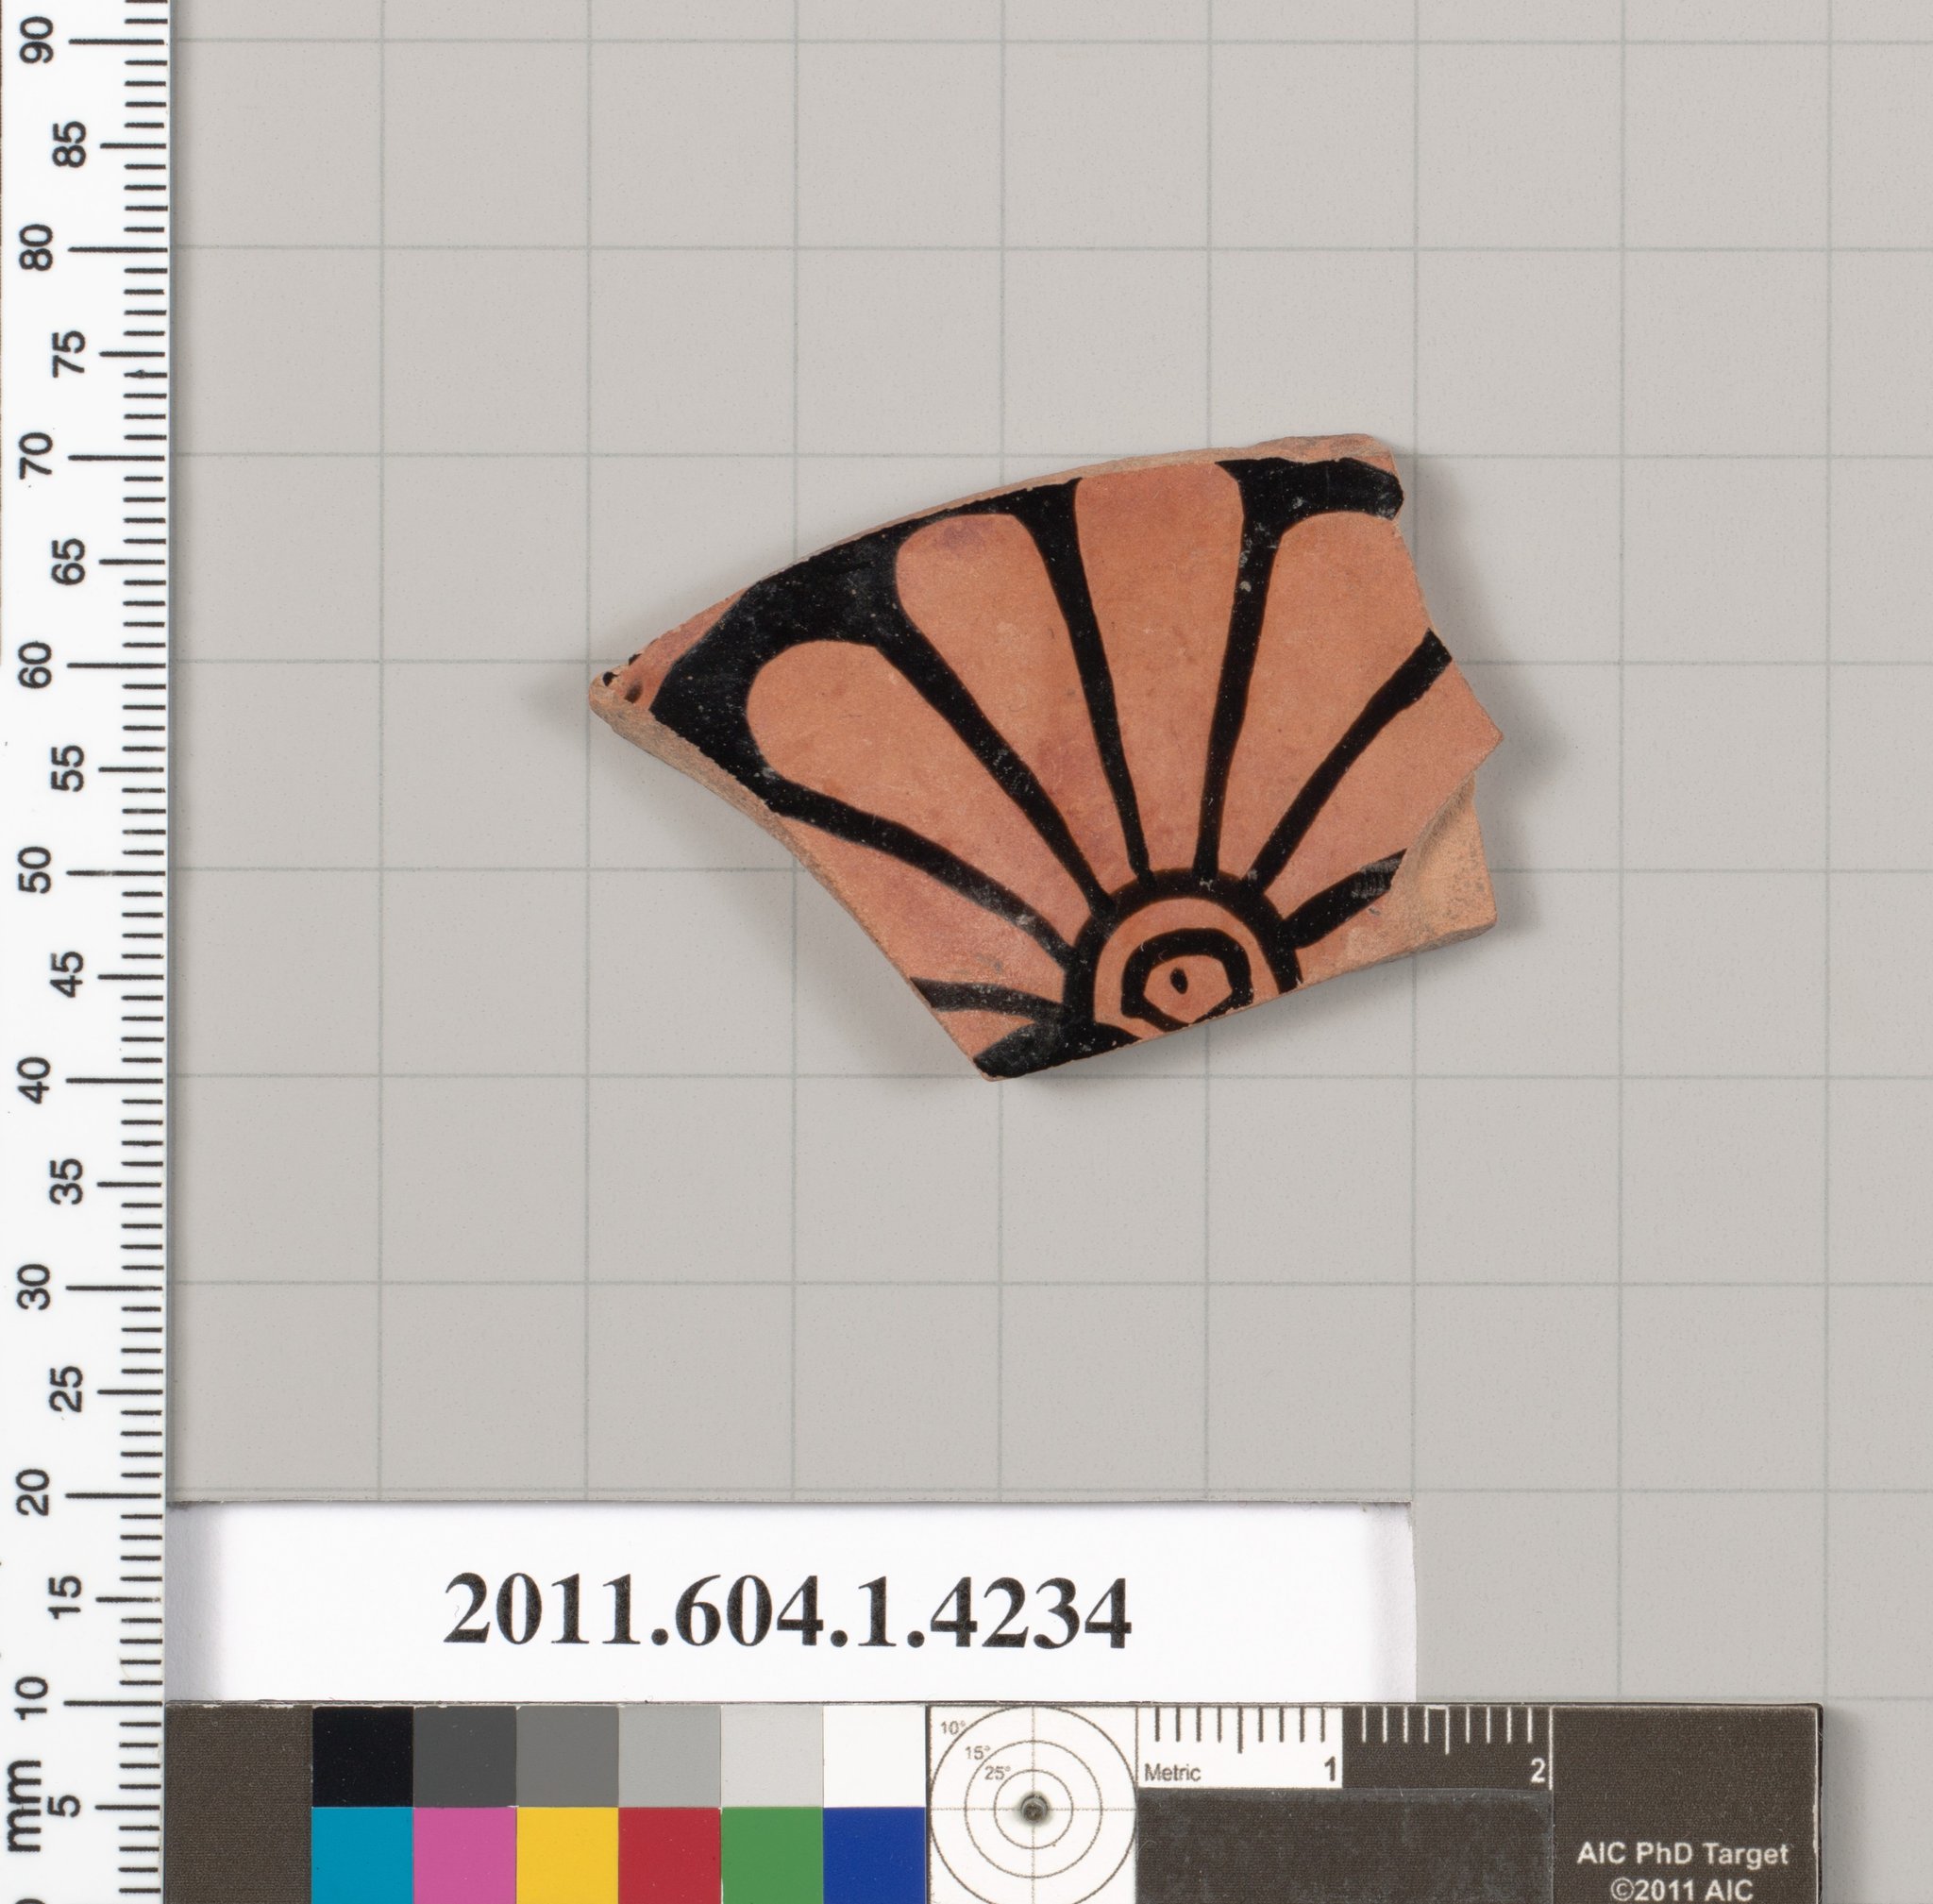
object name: kylix fragment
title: Terracotta fragment of a kylix (drinking cup)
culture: greek, attic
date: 500-476 BCE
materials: terracotta